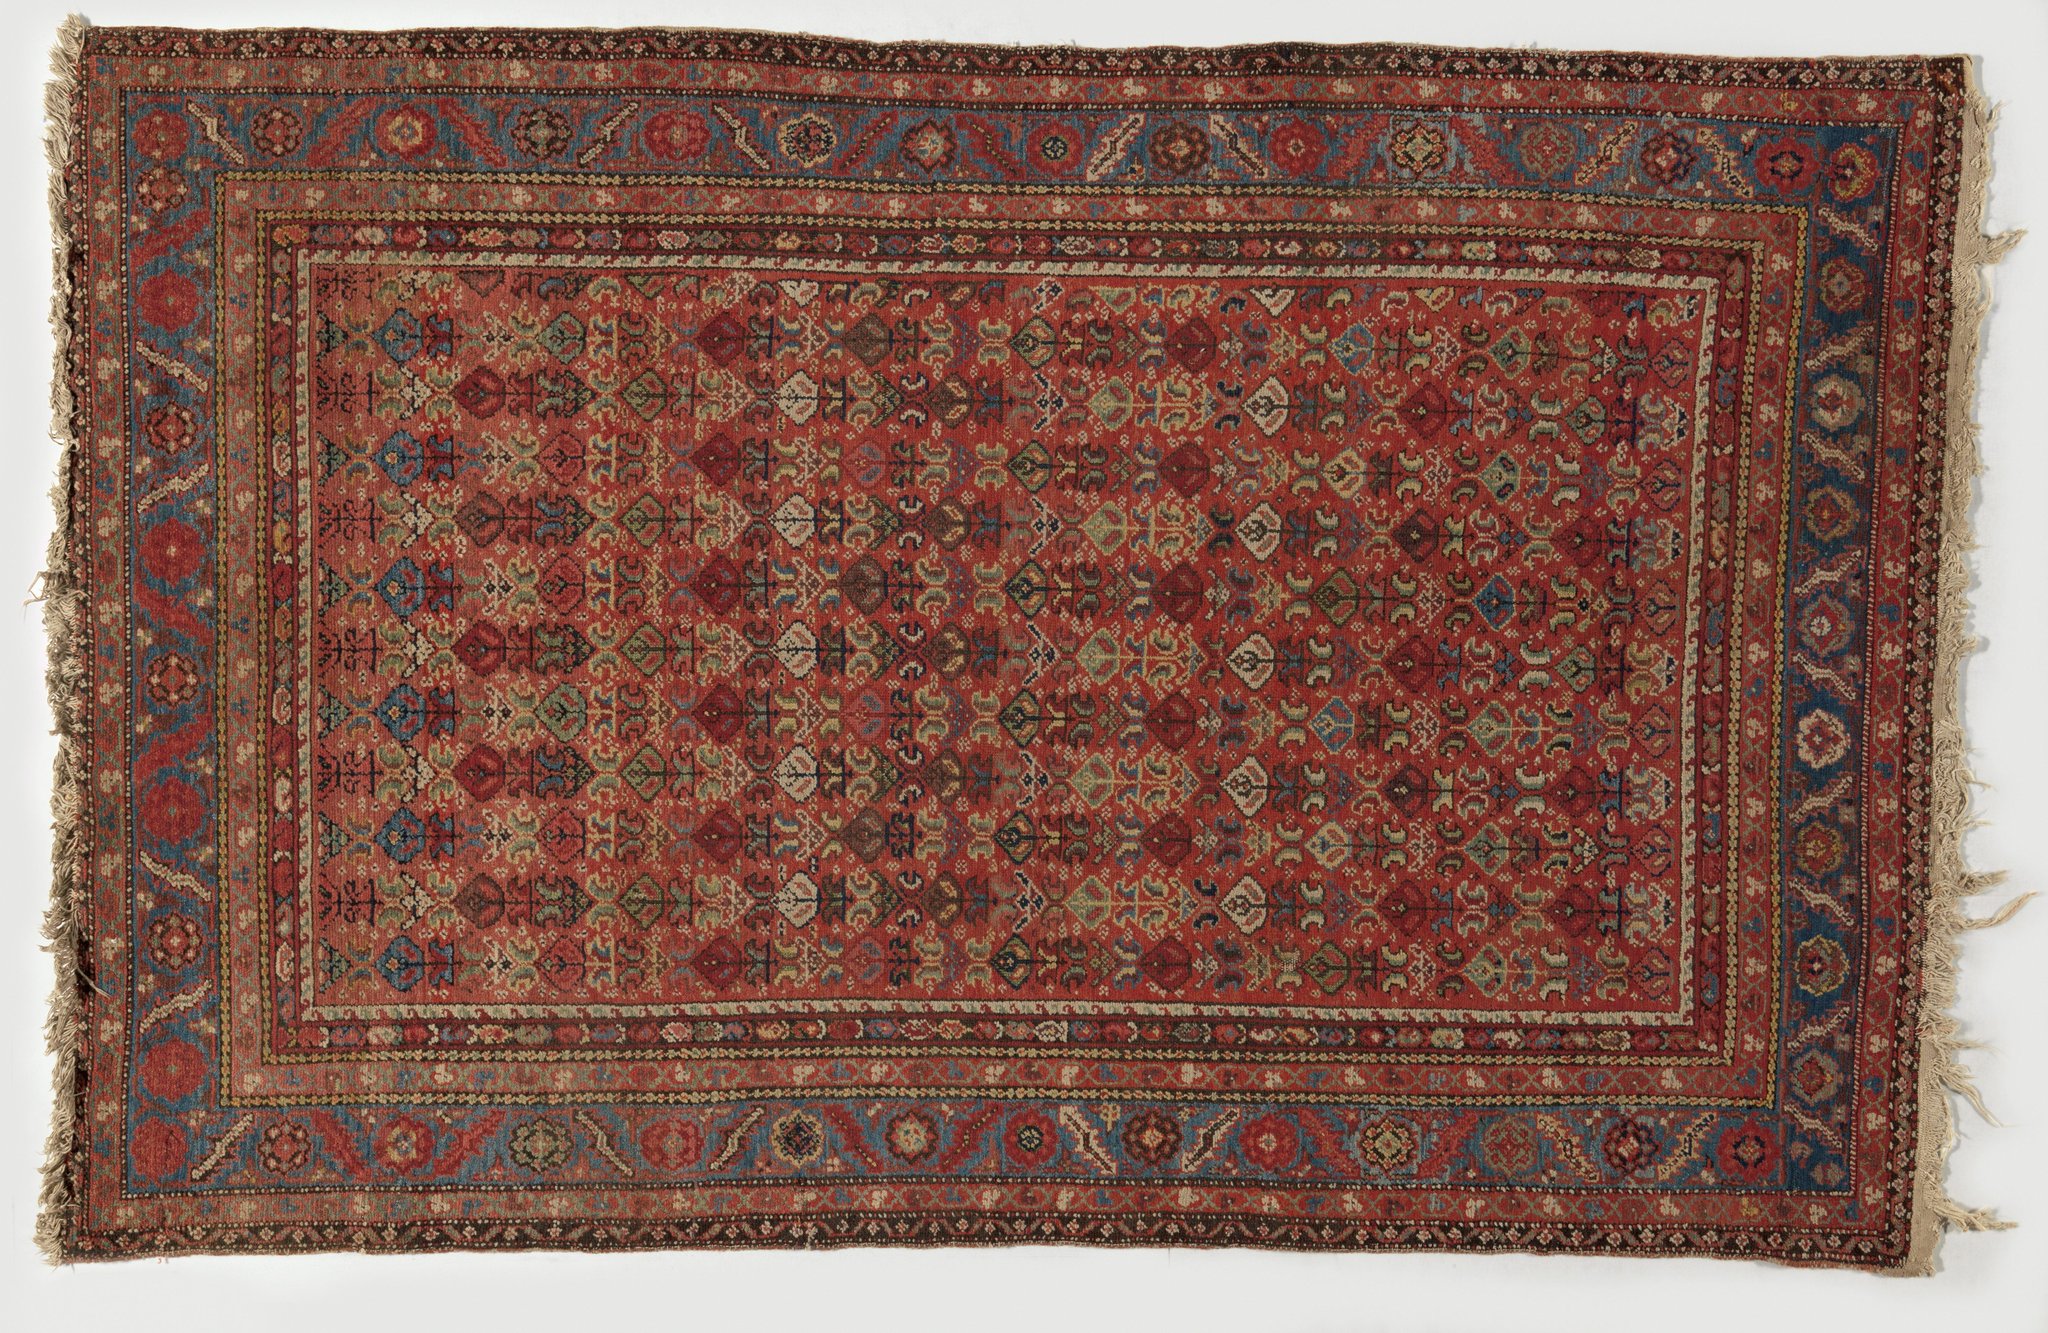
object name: oriental rug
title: Oosters tapijt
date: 1800-1975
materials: cotton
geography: ferahan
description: Oosters tapijt, bloemenkleed. In het middenveld een patroon van florale motieven tegen een lichtrode achtergrond. Meervoudige randen, waarvan de breedste met rozetbloemen aan ranken. Aan de onderzijde een effen witte baard.